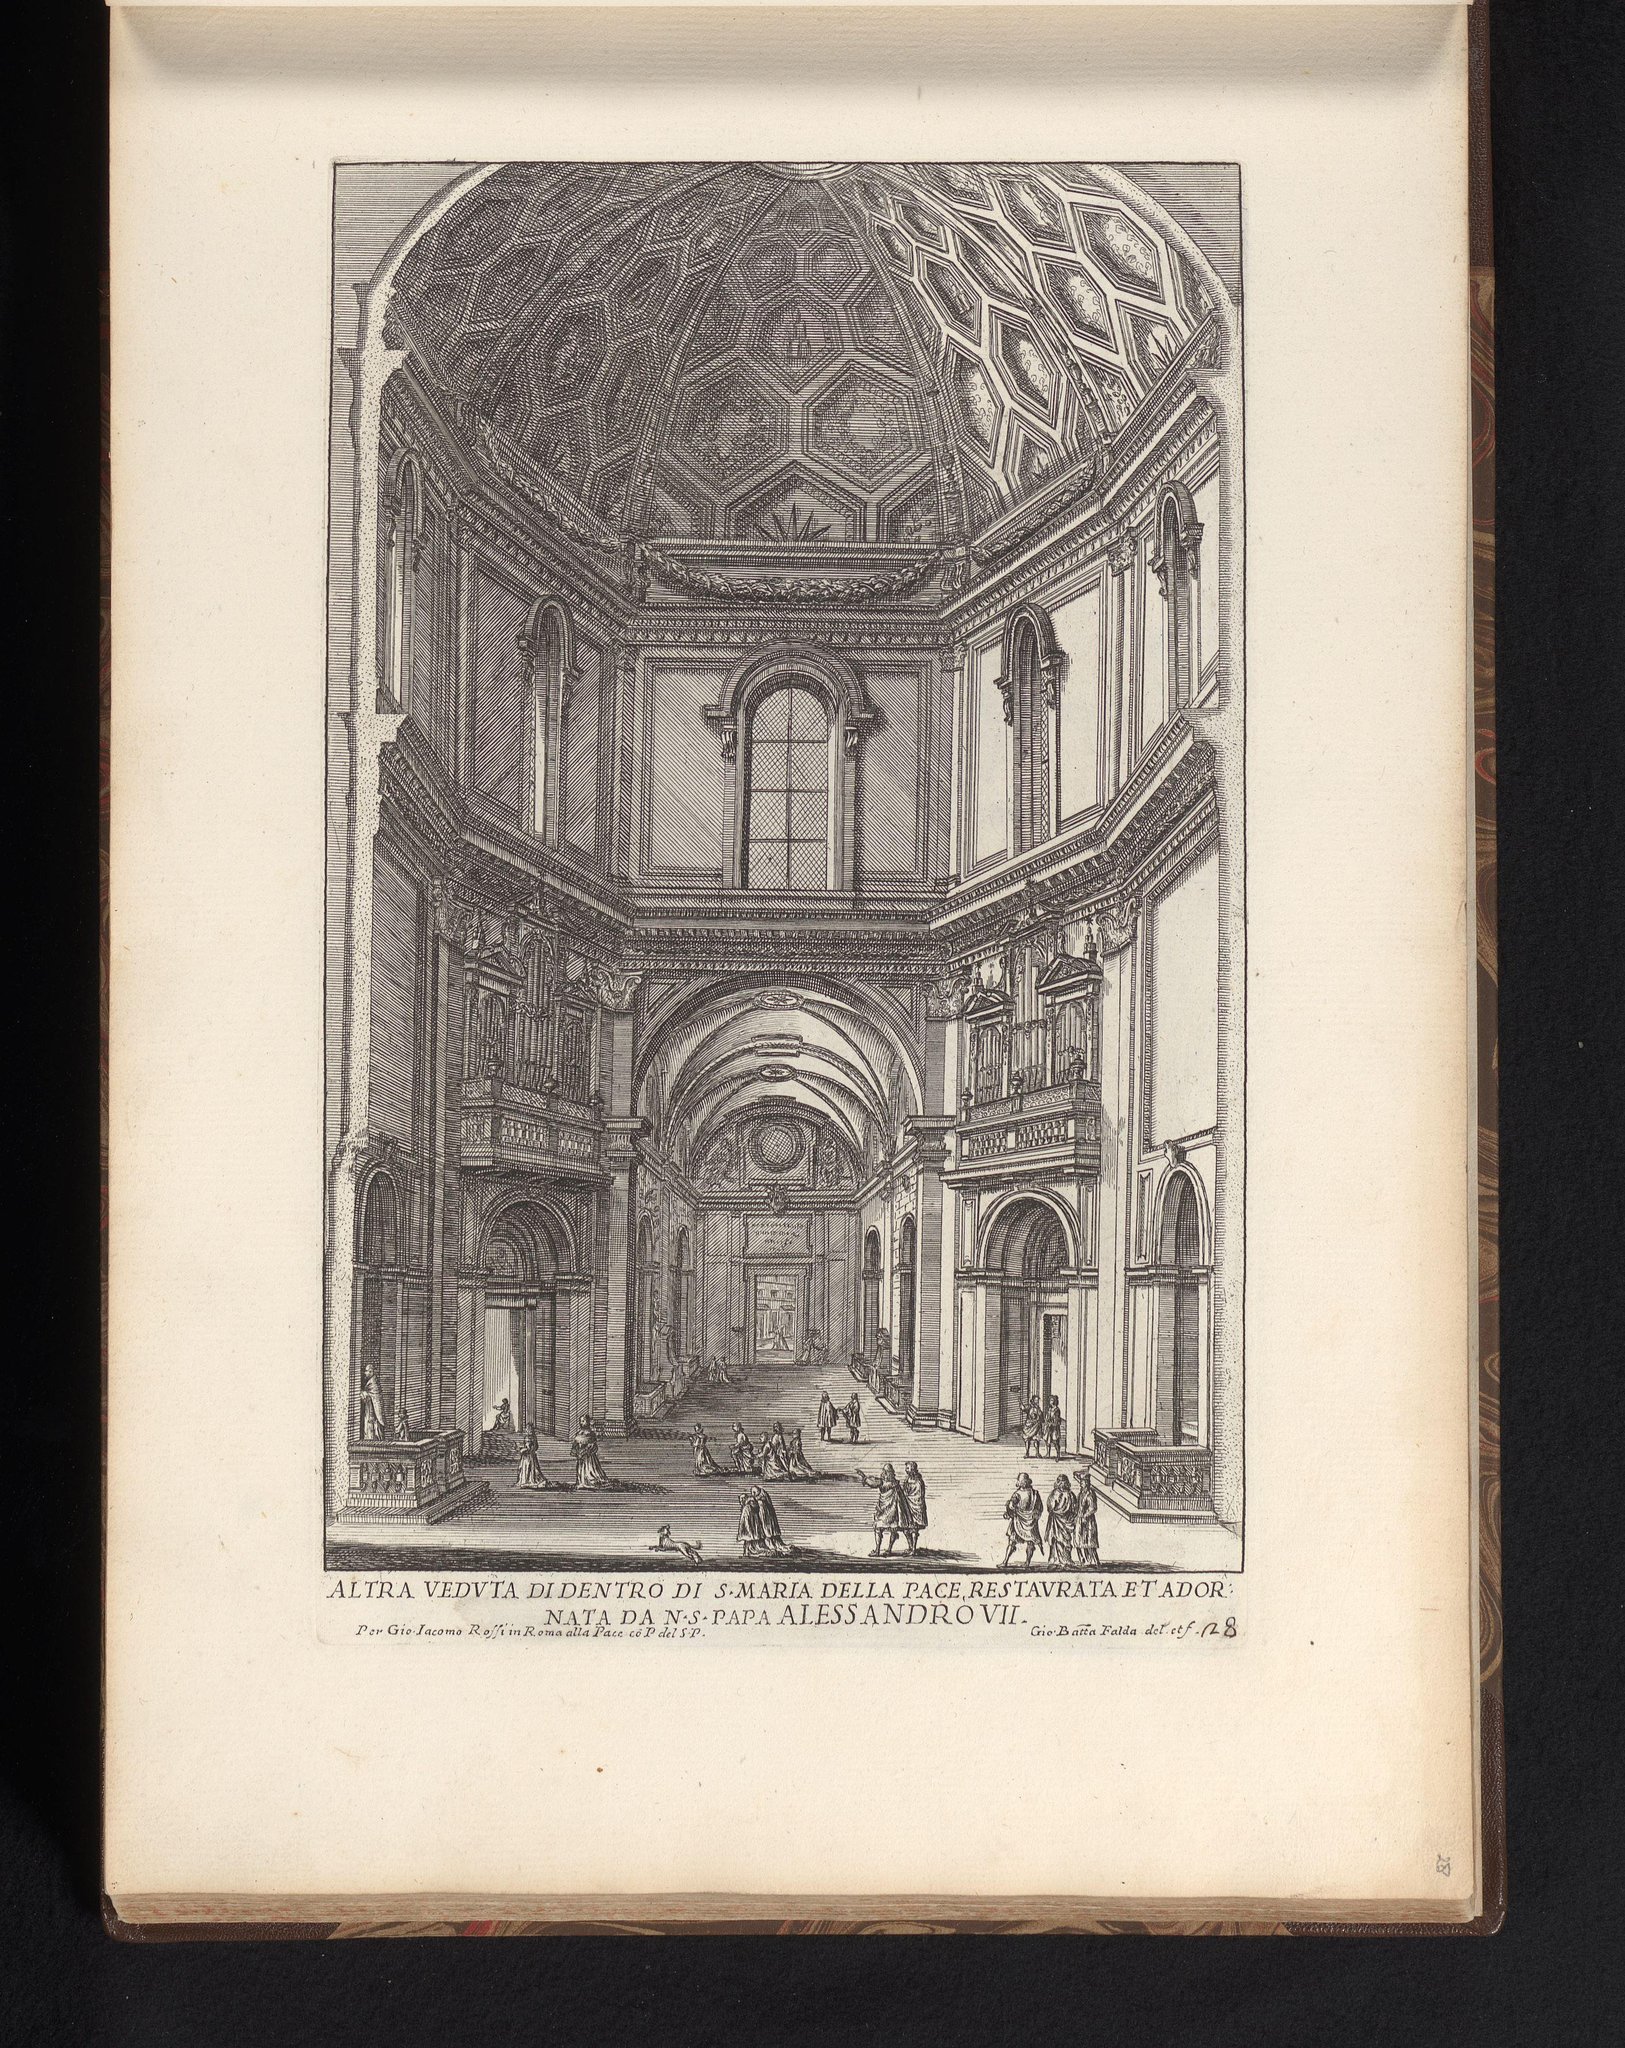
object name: album leaf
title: Moderne gebouwen te Rome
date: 1665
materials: paper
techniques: etching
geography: rome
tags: interior of church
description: Deze prent maakt deel uit van een reeks van 35 prenten met voorstellingen van gebouwen in Rome. Samen met vier andere reeksen vormt het de grote reeks: 'Il nuovo teatro di Roma moderna'.